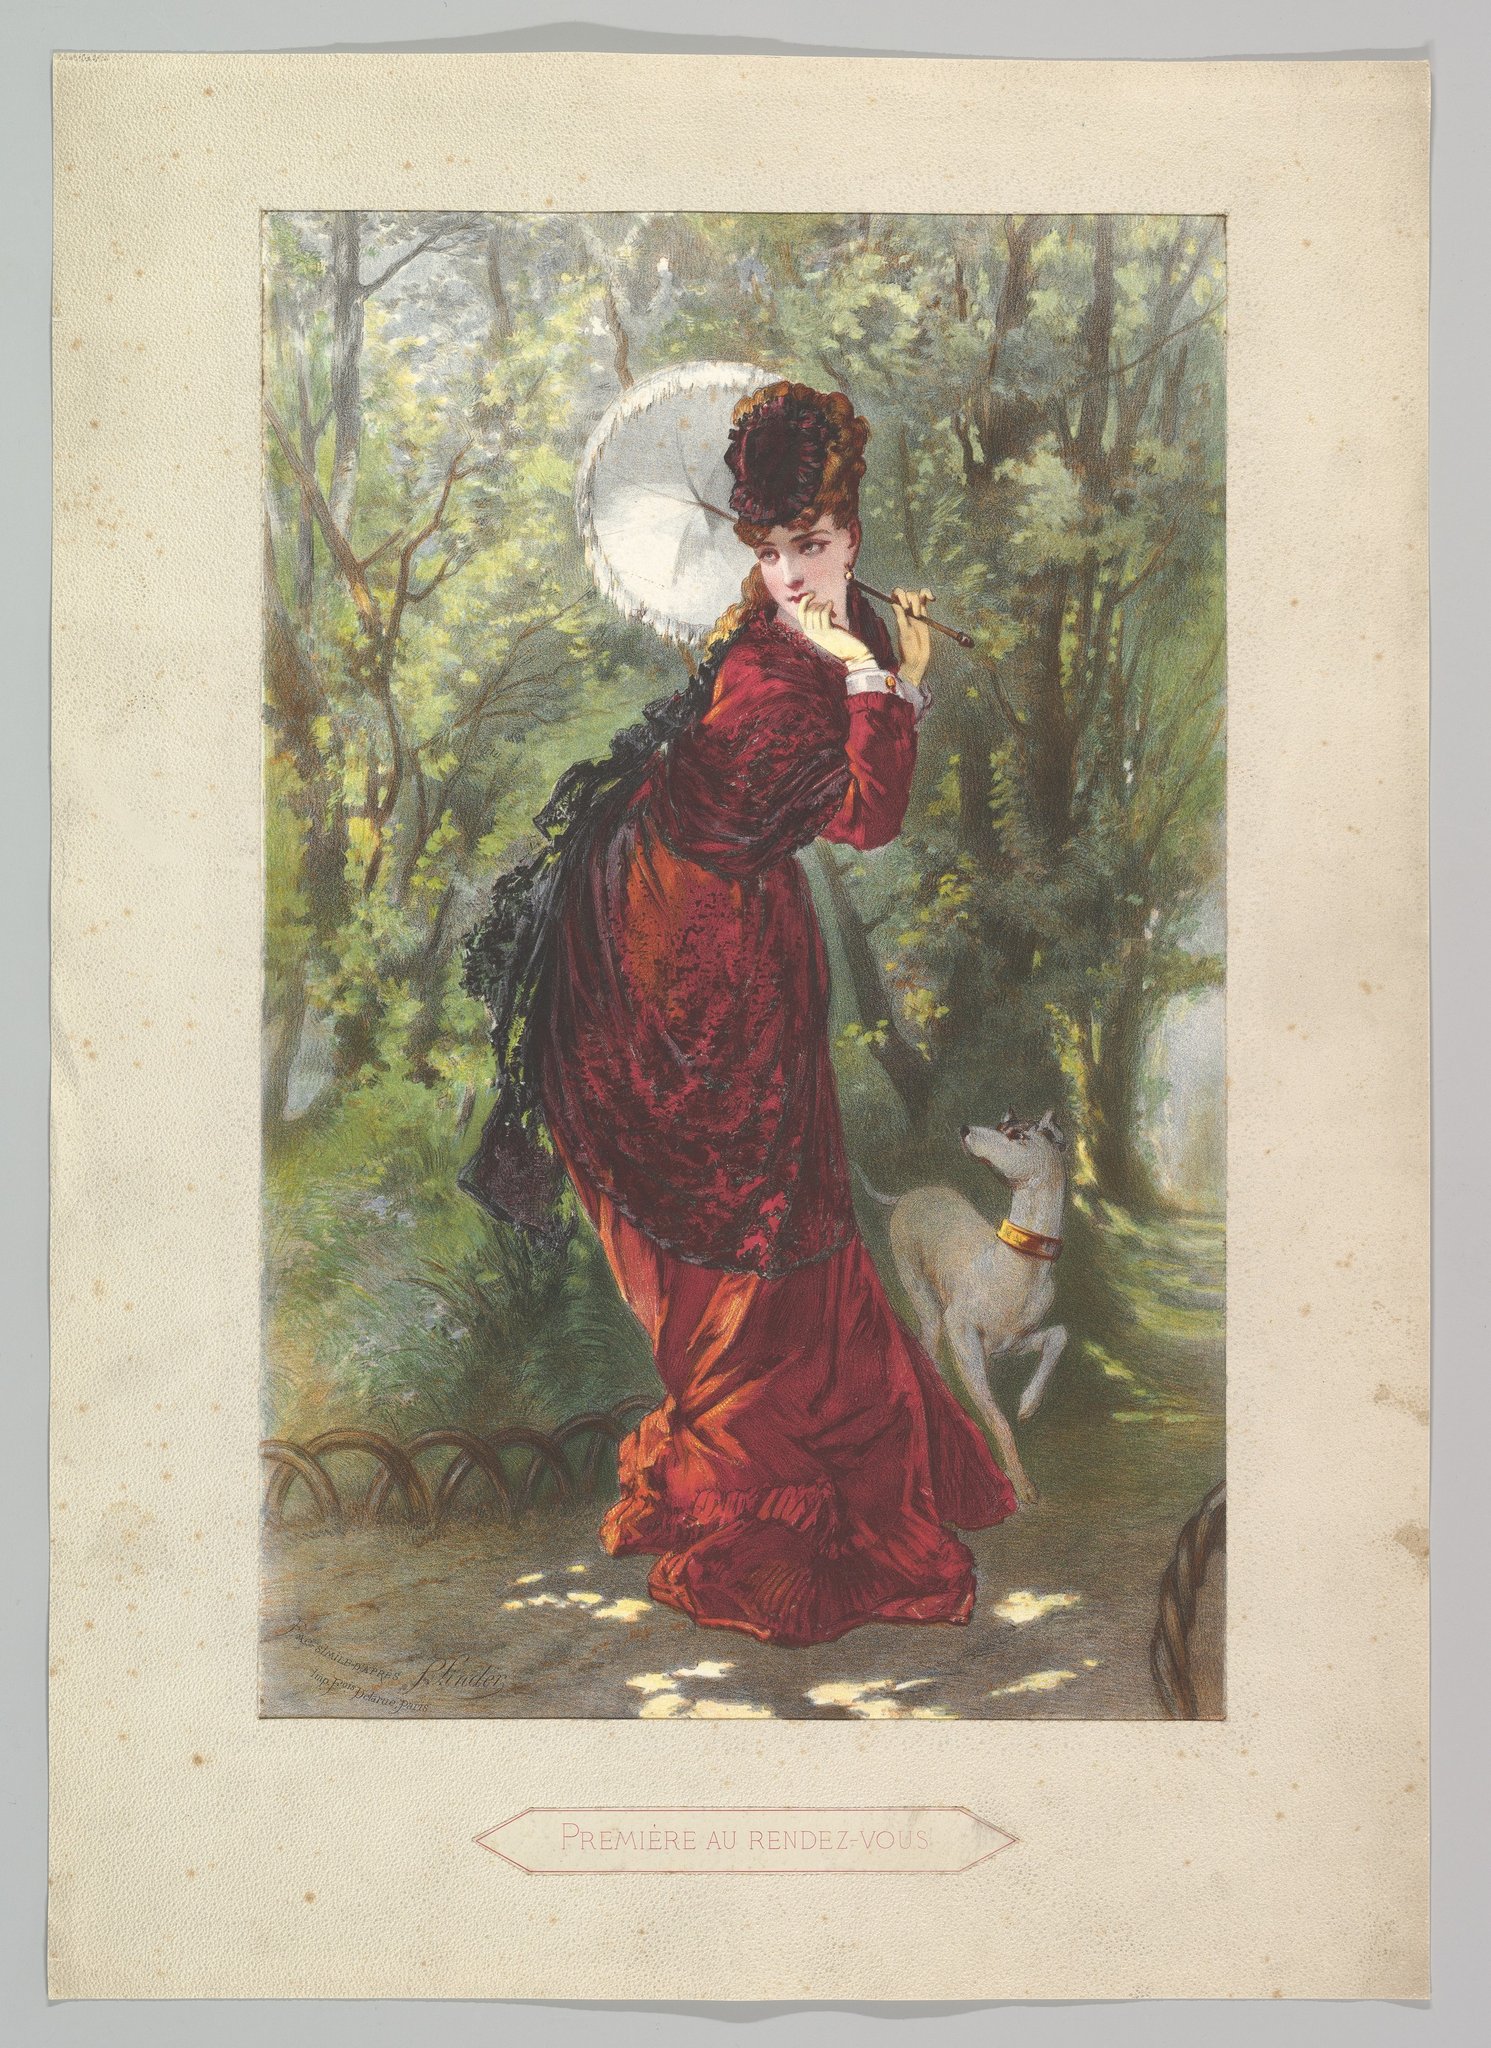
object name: print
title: Première au Rendez-vous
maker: anonymous, french, 19th century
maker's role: artist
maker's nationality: french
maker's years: 1800-1900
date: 1800-1899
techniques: lithograph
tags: women,dogs